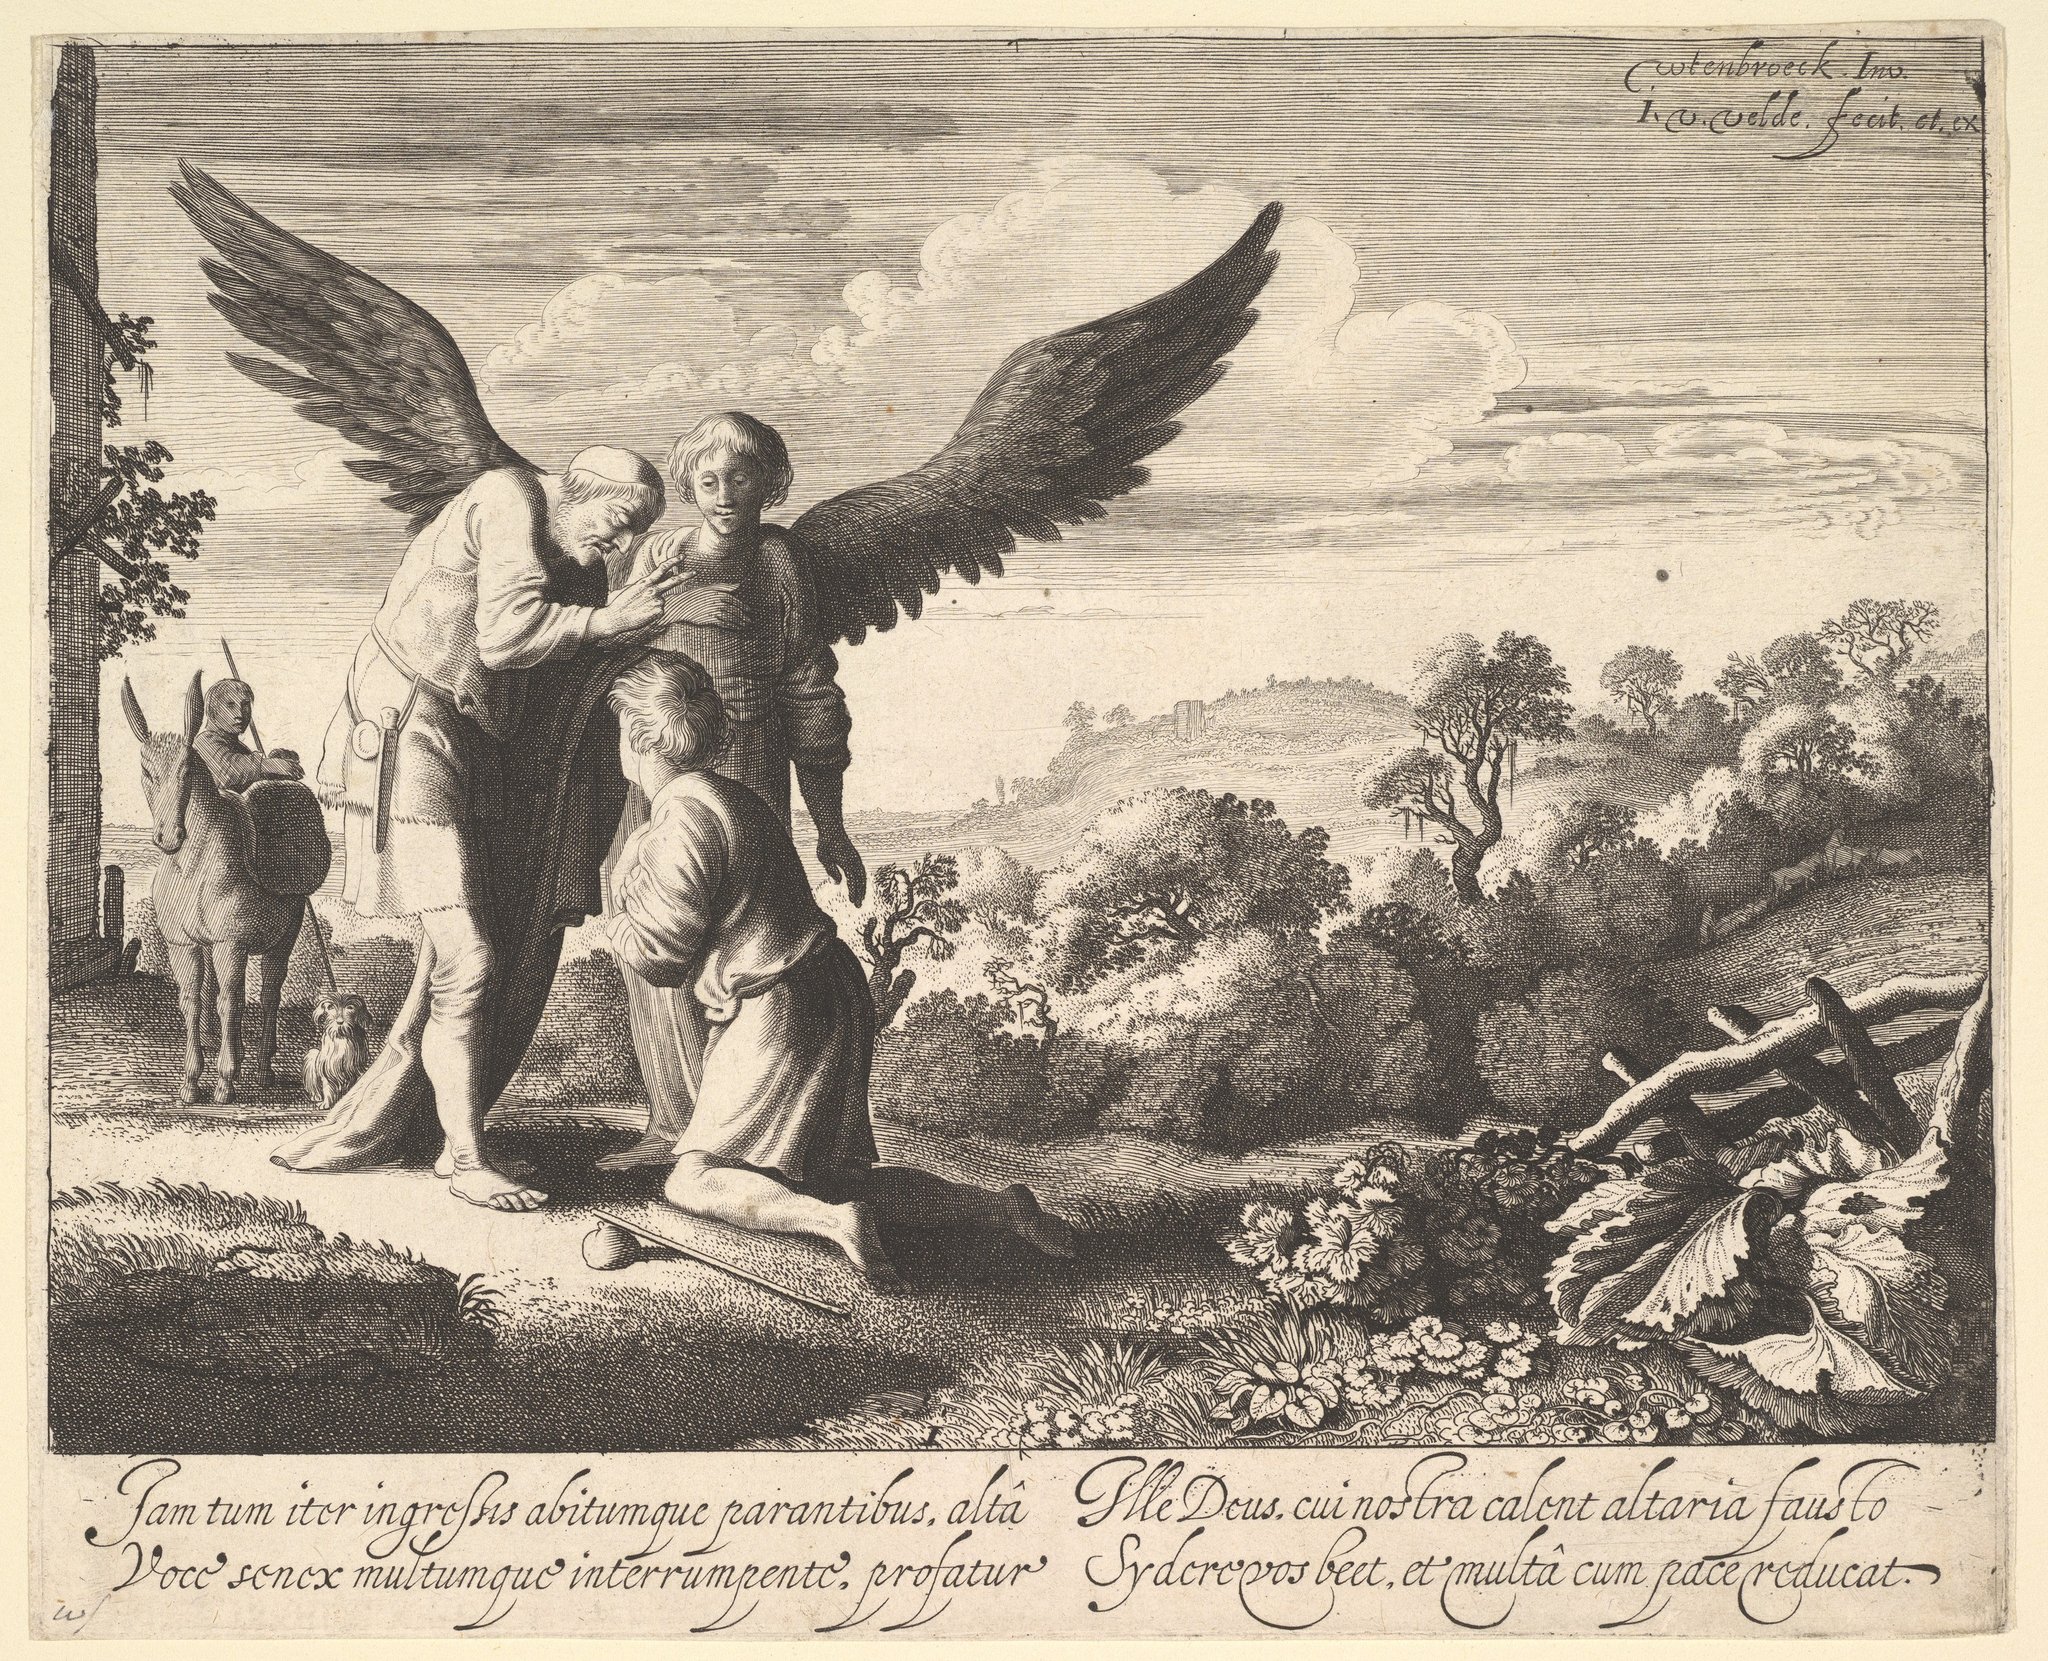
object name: print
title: Tobias Blessed by Blind Tobit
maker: jan van de velde ii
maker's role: artist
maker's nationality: dutch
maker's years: 1593-1641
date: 1620-1641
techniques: engraving, etching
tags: animals,landscapes,angels